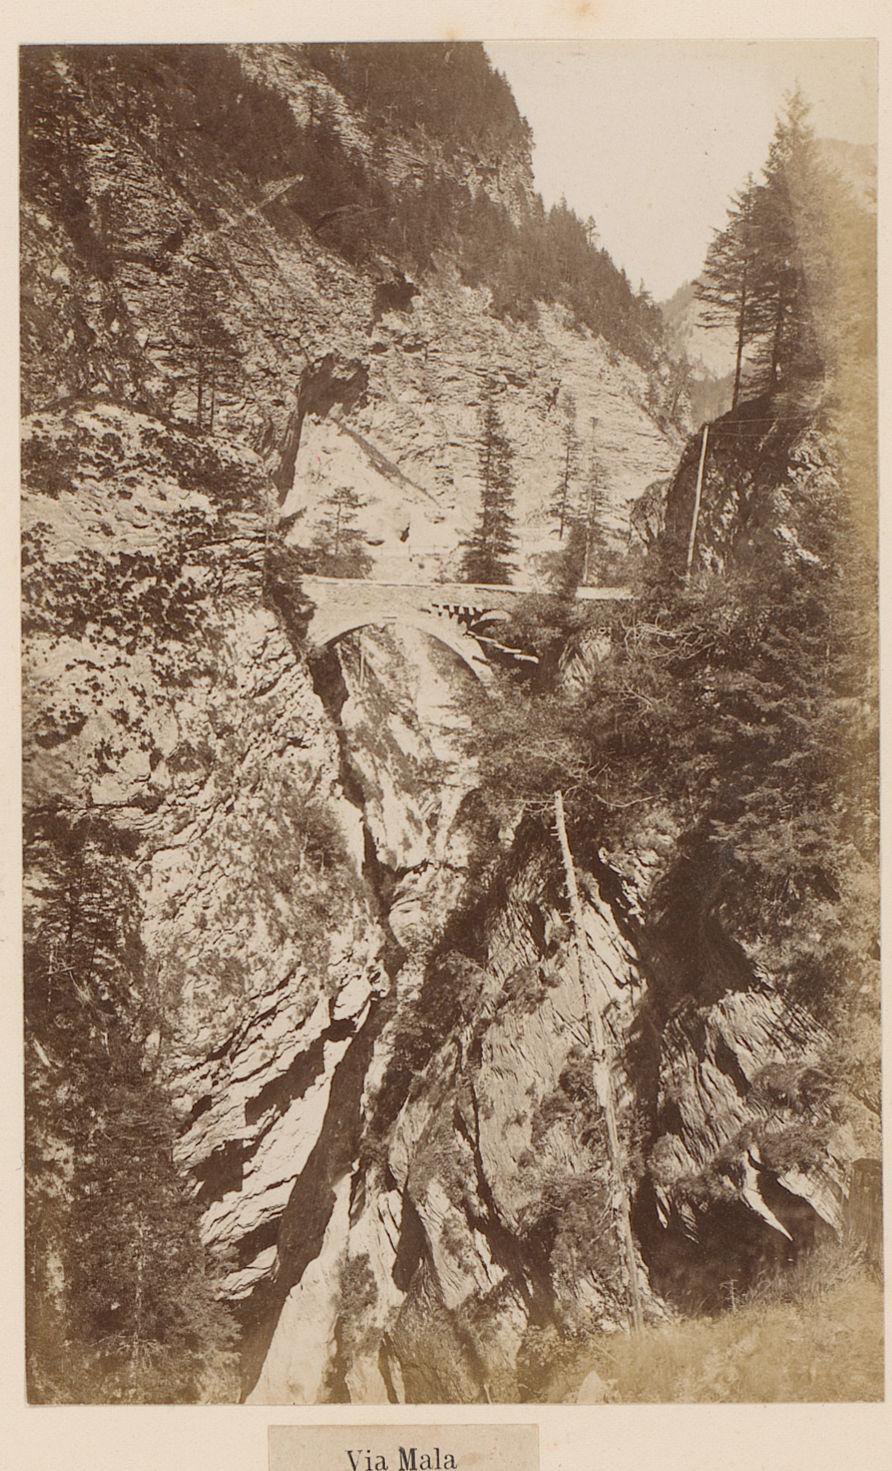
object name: photograph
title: Via Mala. Premier pont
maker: Anonymous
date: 1860-1890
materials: paper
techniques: albumen print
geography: via mala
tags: landscape with bridge, viaduct or aqueduct, ravine, chasm, abyss, canyon